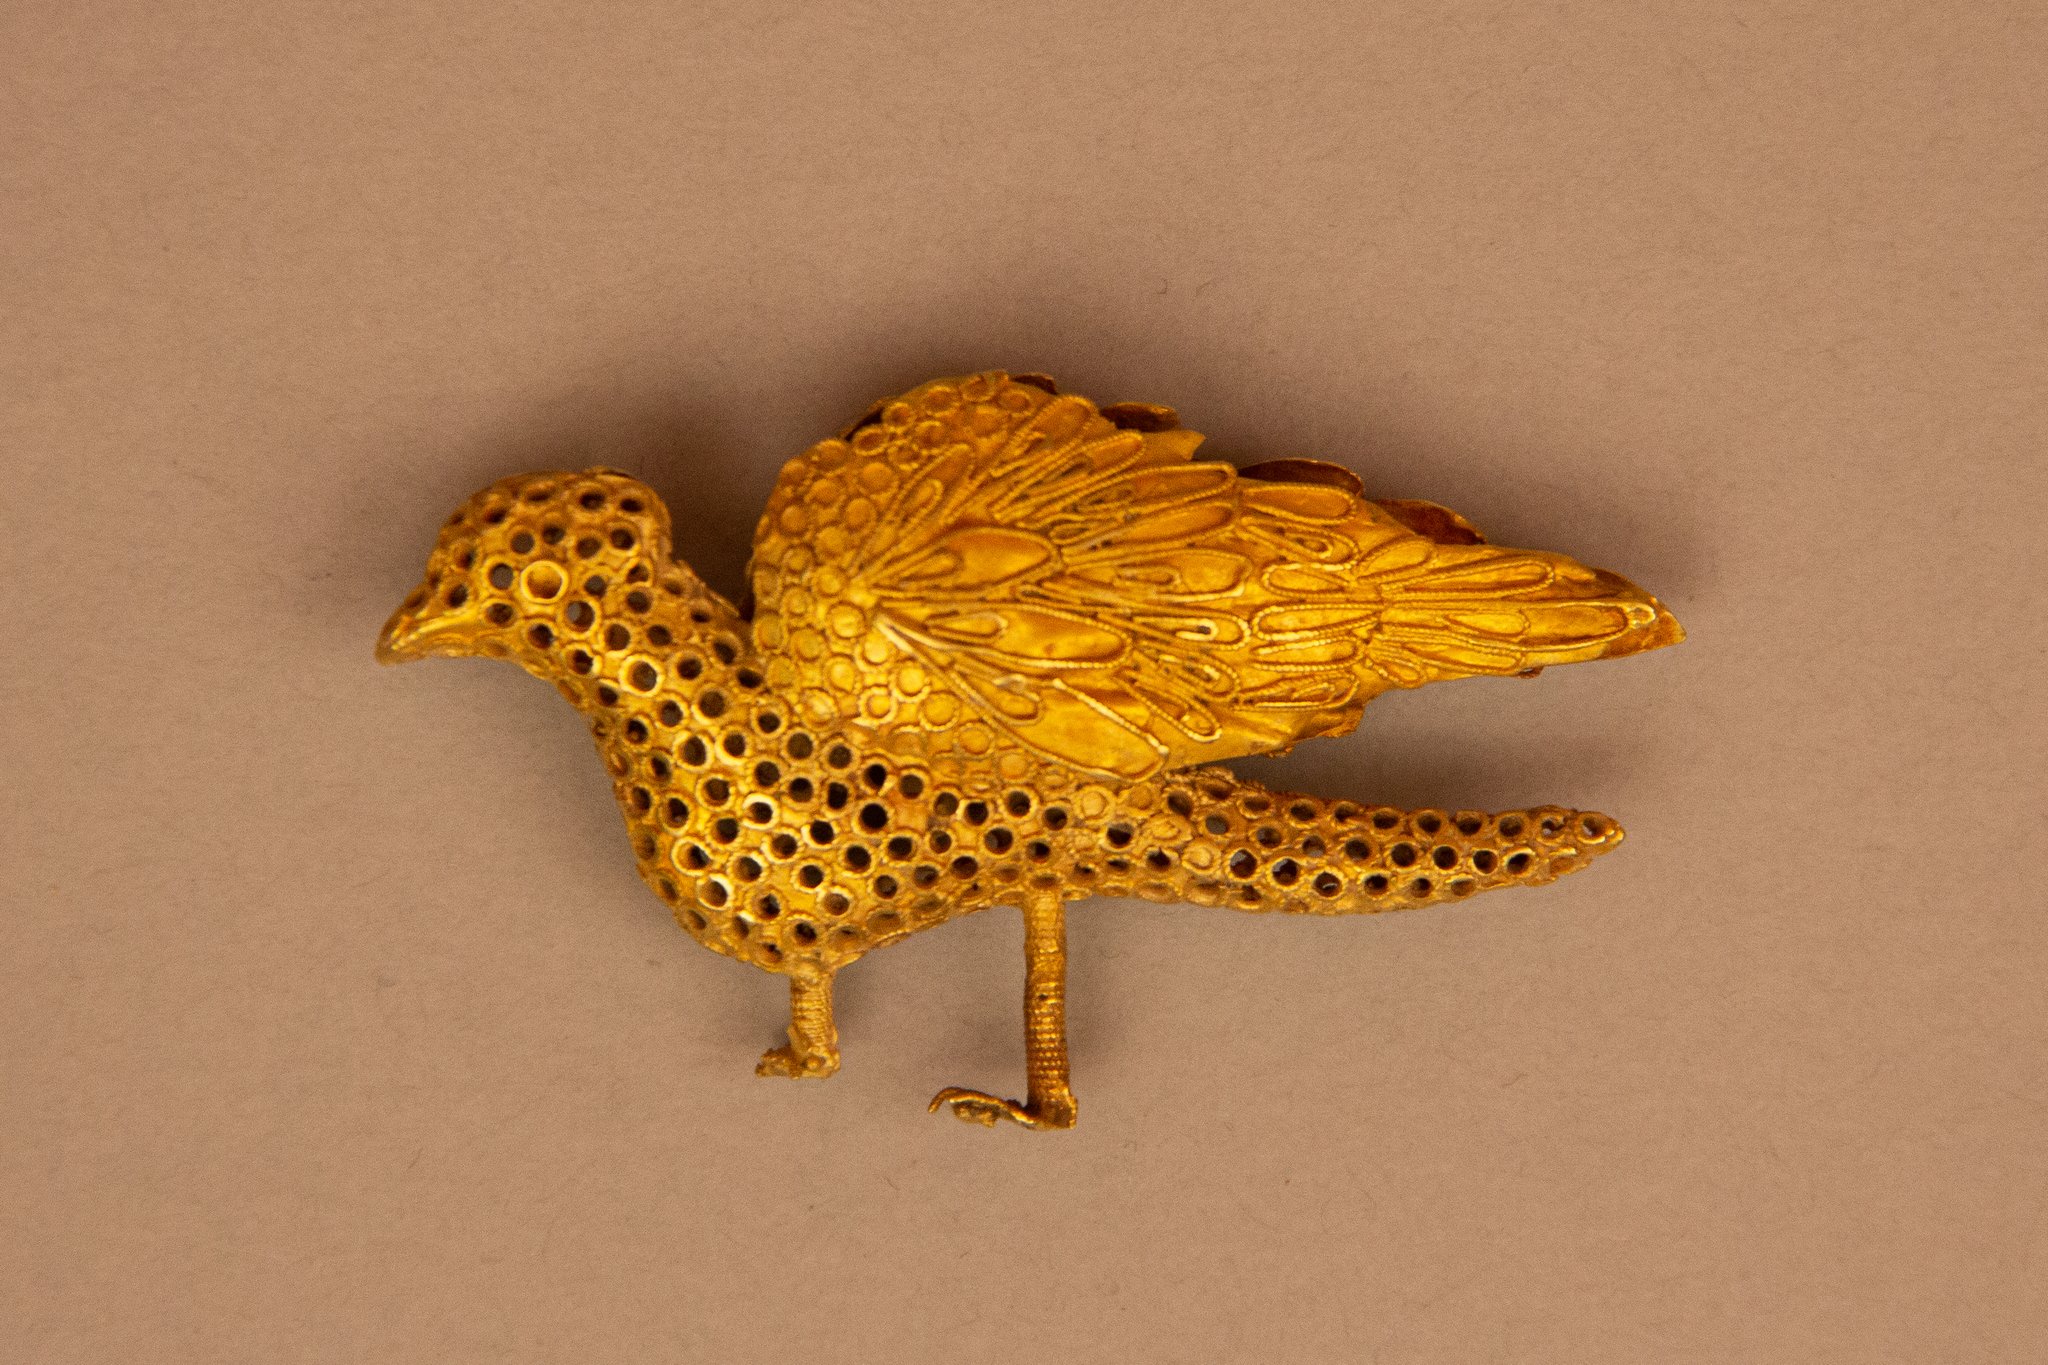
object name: pendant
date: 1101-1200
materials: gold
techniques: filigree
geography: iran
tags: birds